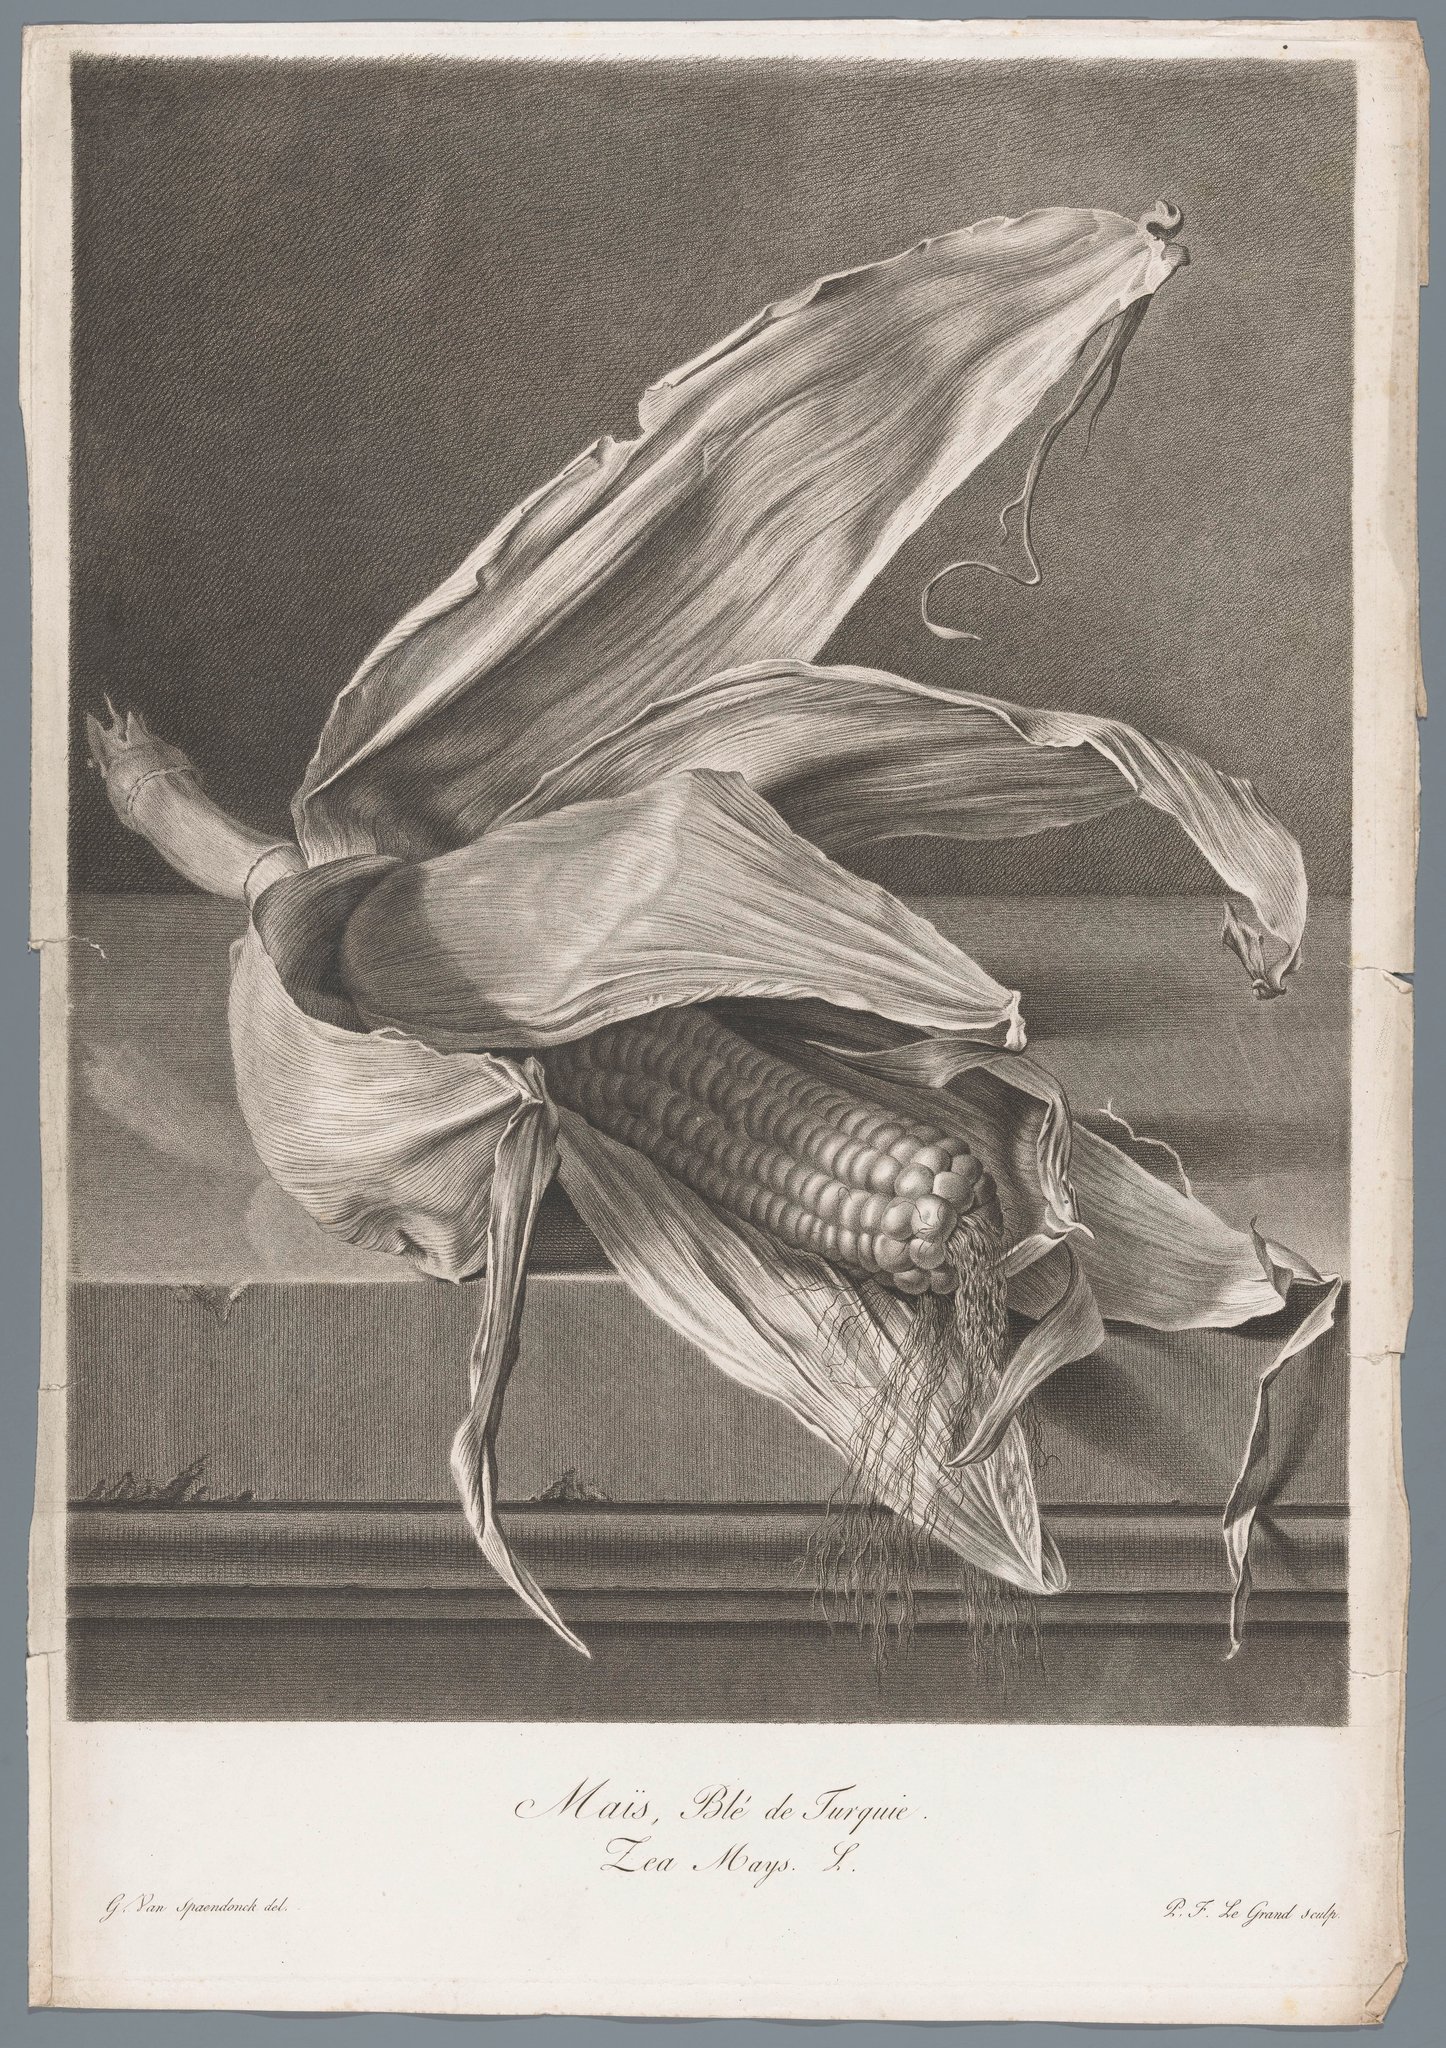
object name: ornament print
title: Fleurs dessinées d'après nature (...)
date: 1799-1801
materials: paper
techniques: engraving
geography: paris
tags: cereal, grain, corn (grass with grains, grown for food, e.g.: wheat, rice, rye, oats, maize, buckwheat, millet)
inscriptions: collector's mark: Lugt 2228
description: De serie Fleurs dessinées d'après nature (...) bestaat uit 24 prenten verdeeld over zes omslagen. Het Rijksprentenkabinet heeft 23 prenten in zes omslagen in bezit. De verdeling over de omslagen lijkt willekeurig. Zie RP-P-1909-4220 t/m 4242 en RP-P-2016-53 t/m 58.